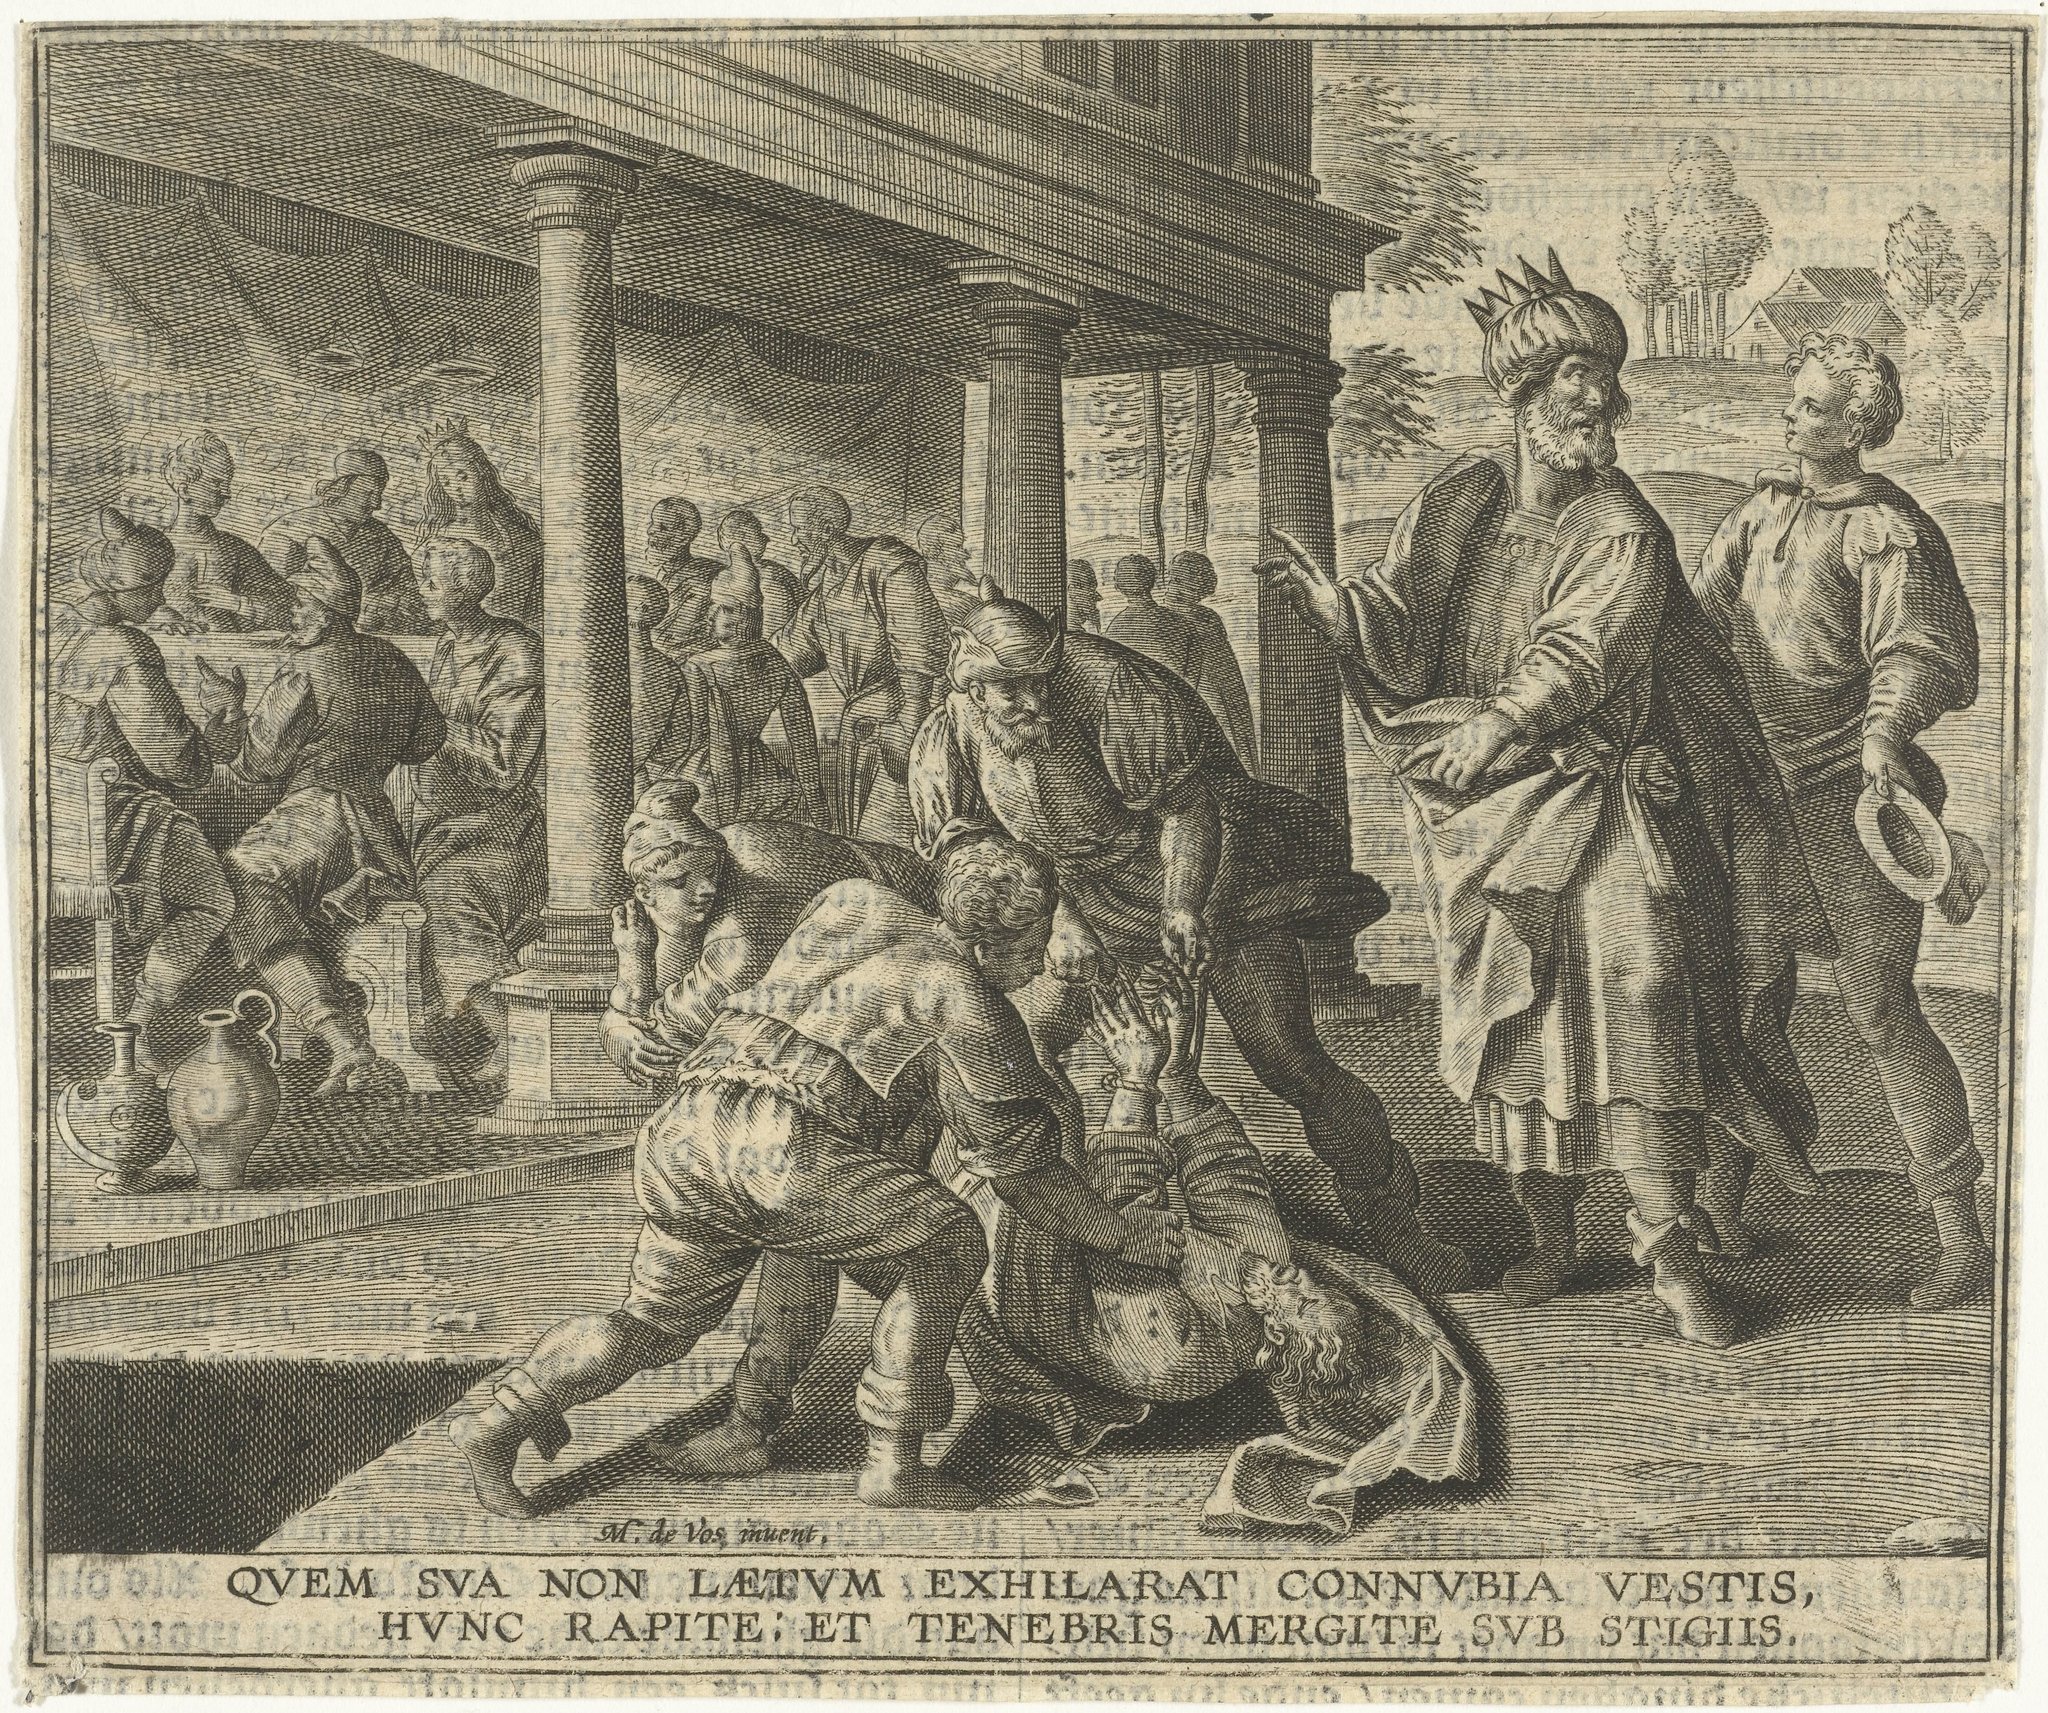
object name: book illustration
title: Gelijkenis van de koninklijke bruiloft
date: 1597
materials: paper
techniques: engraving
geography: antwerp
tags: the unworthy guest is dragged out ~ parable of the royal wedding-feast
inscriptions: collector's mark: Lugt 2228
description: Een scène uit de gelijkenis van de koninklijke bruiloft. Een van de gasten is zonder bruiloftskleed naar het feest gekomen. De koning geeft het bevel de gast zijn handen en voeten vast te binden en hem uit de zaal te gooien. De prent heeft een Latijns onderschrift.